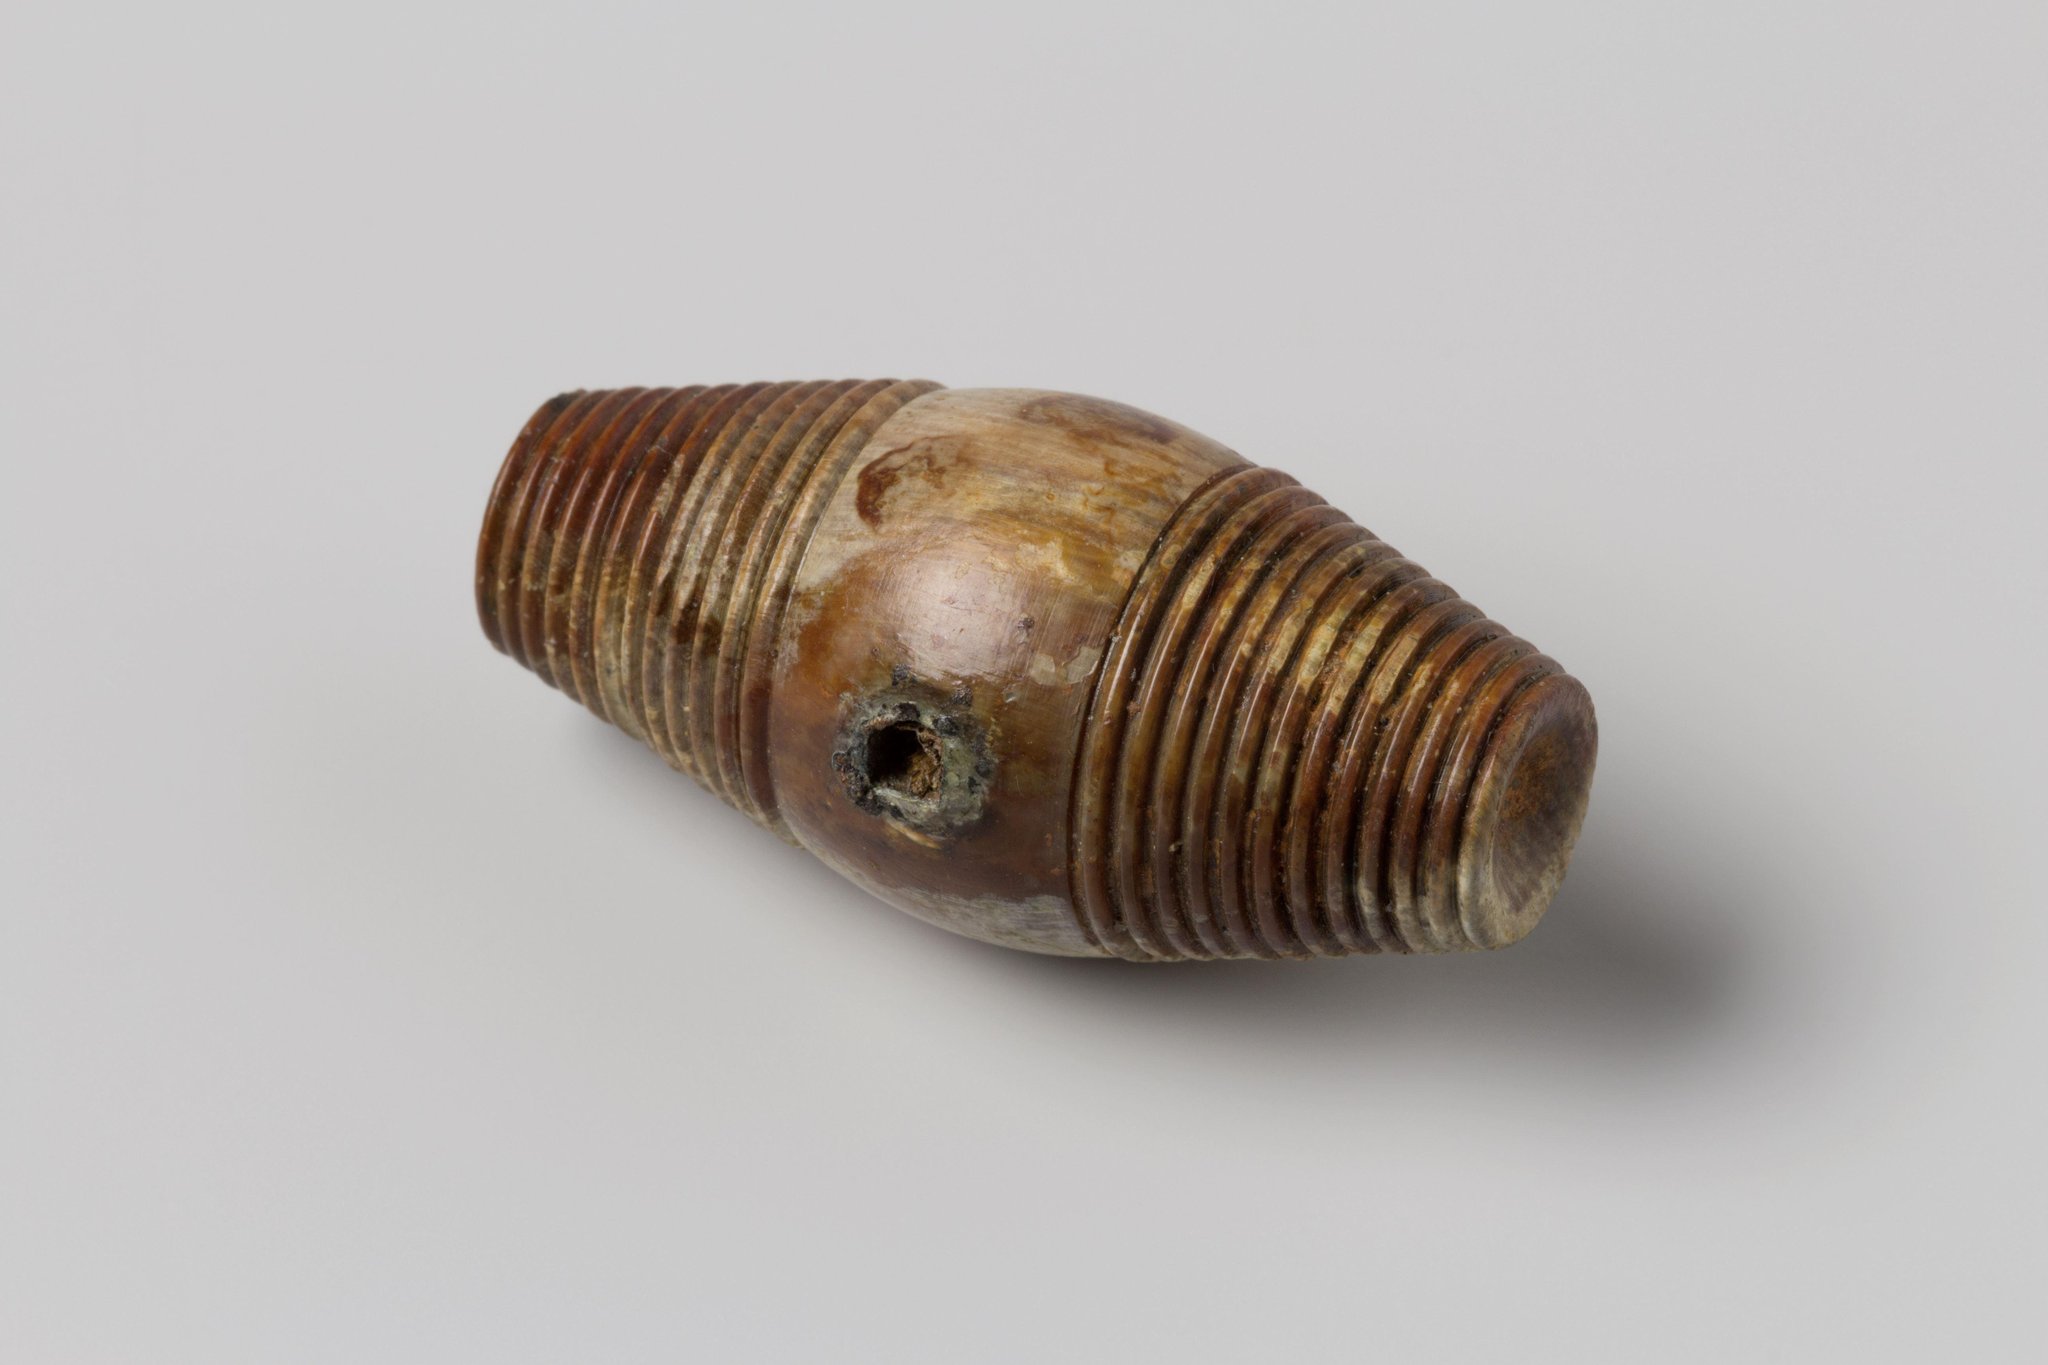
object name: toggle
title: Knevel uit het wrak van de Oost-Indiëvaarder Hollandia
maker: Anonymous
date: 1700-1743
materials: bone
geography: netherlands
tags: verenigde oostindische compagnie, hollandia (schip), annet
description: Knevel. Toggle; (1) sim. NG 1980-27H684, (4.1l), centre more bulbous (centre 2d, ends 1d), square hole through centre (0.3 x 0.3).